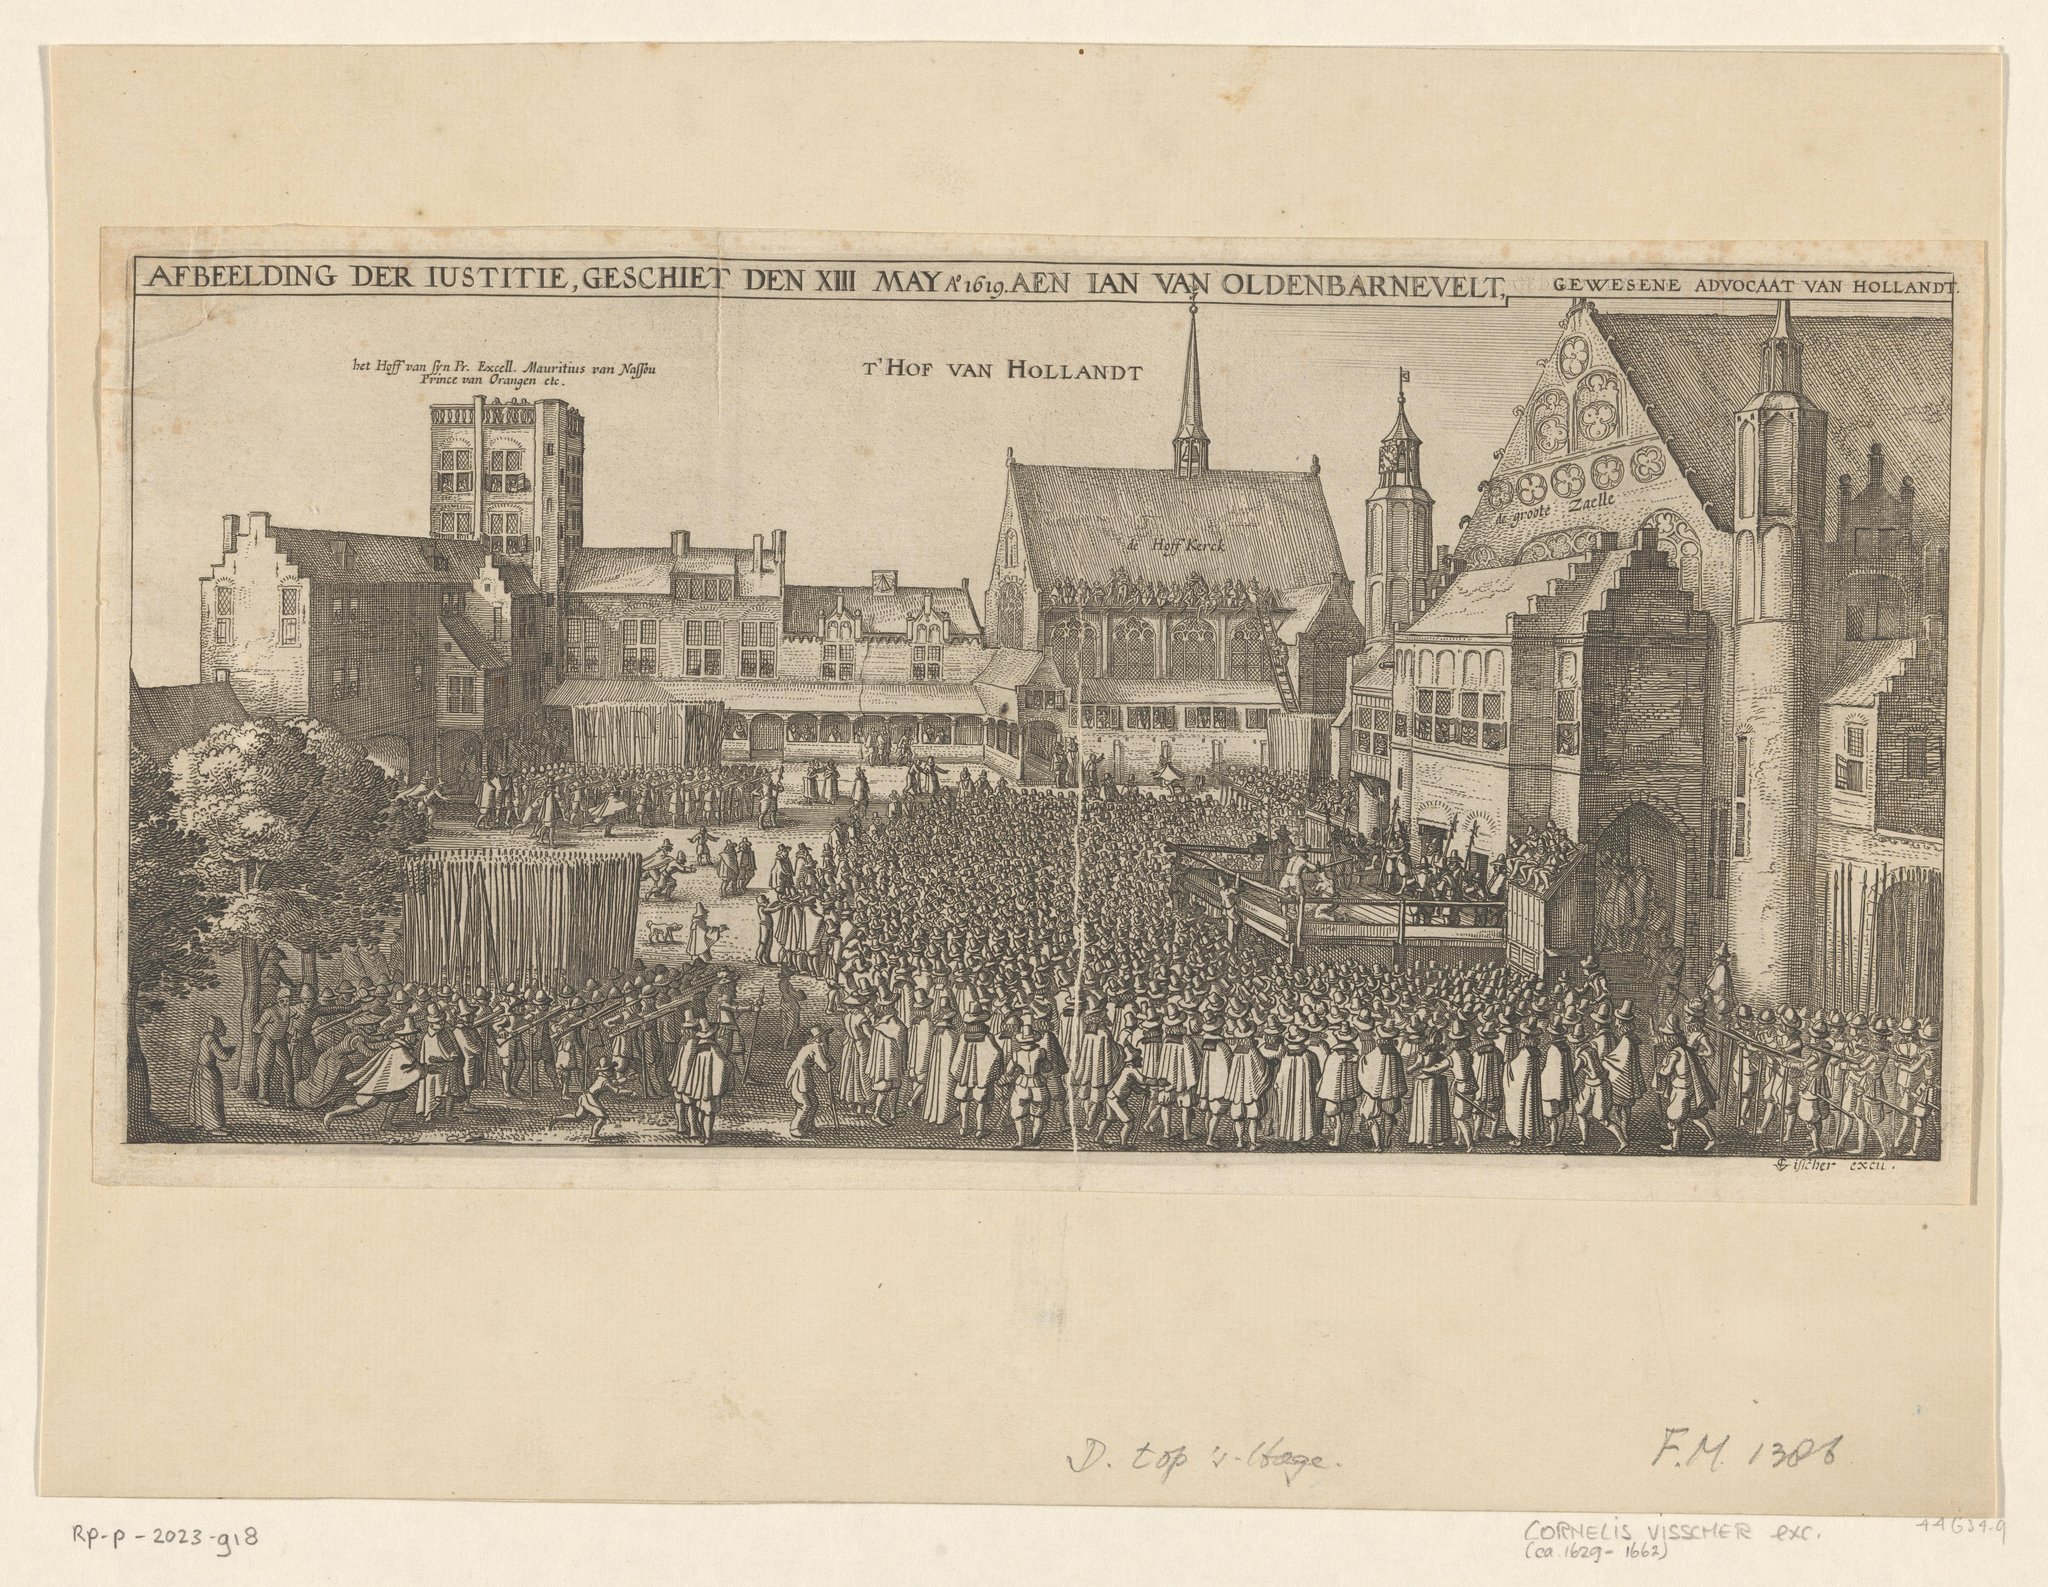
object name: print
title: Onthoofding van Johan van Oldenbarnevelt, 1619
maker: claes jansz. visscher (ii)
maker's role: draughtsman, print maker, publisher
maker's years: 1586-1652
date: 1619-1621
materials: paper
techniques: engraving, etching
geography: amsterdam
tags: the hague, johan van oldenbarnevelt, historical persons, death penalty, execution, violent death by beheading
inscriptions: collector's mark: Lugt 2228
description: De onthoofding van Johan van Oldenbarnevelt op het Binnenhof te Den Haag op 13 mei 1619. Gezicht op het plein met alle omringende gebouwen en het verzamelde publiek. In de toren linksboven het hof van prins Maurits.